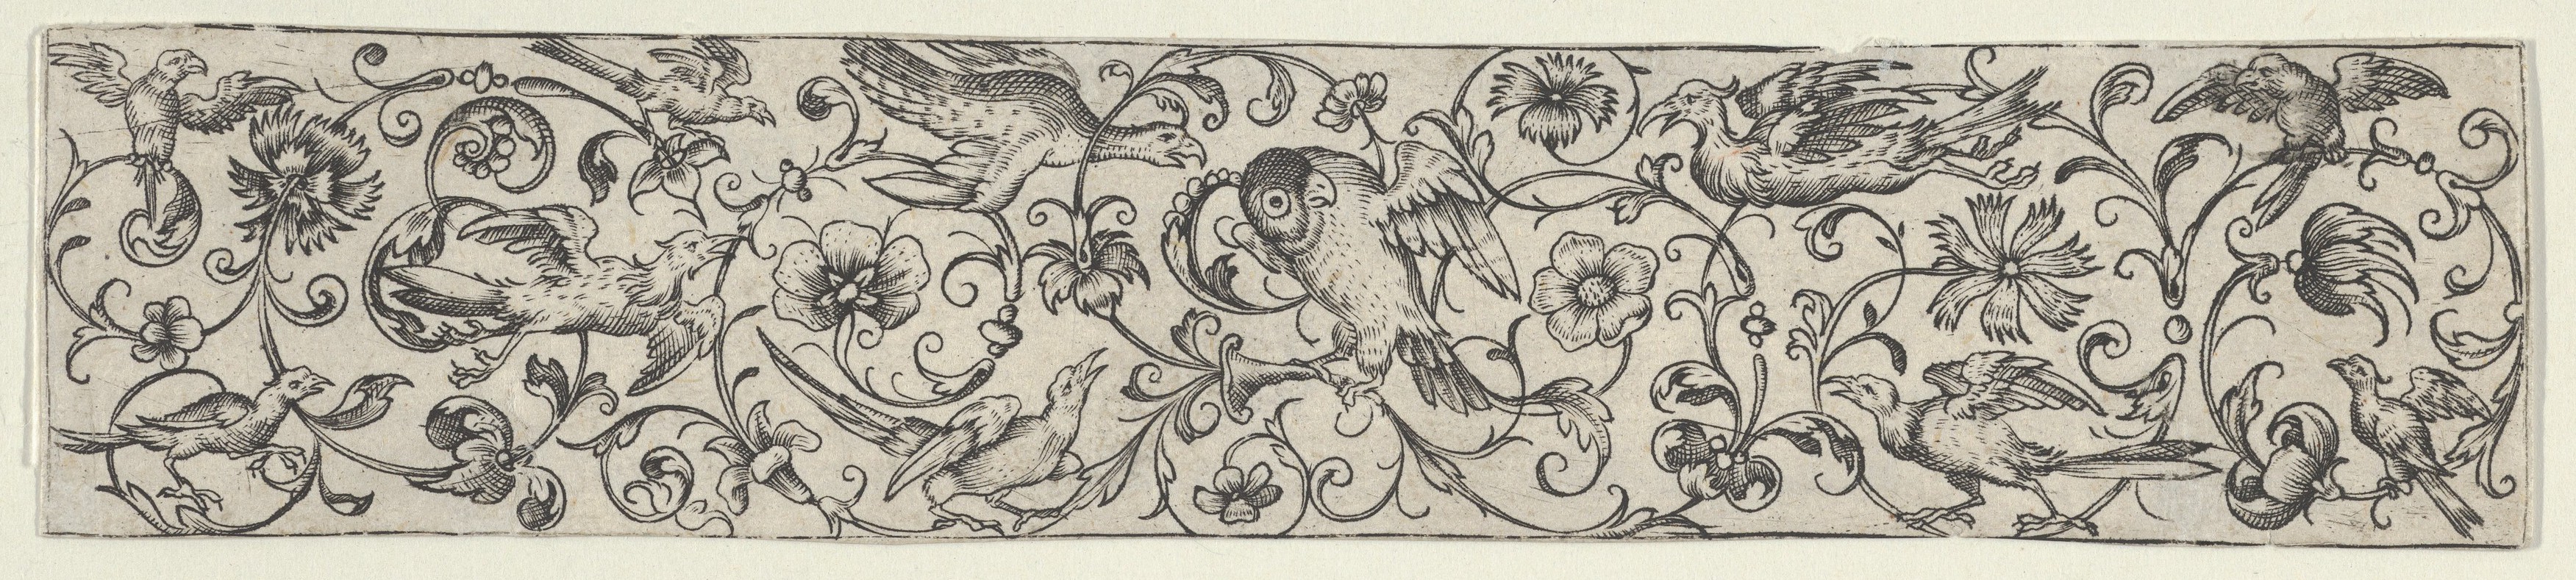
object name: print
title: Frieze with Birds Perched on Scrolling Tendrils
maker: hieronymus bang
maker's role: artist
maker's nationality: german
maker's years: 1553-1630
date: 1568-1633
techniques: engraving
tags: birds,flowers